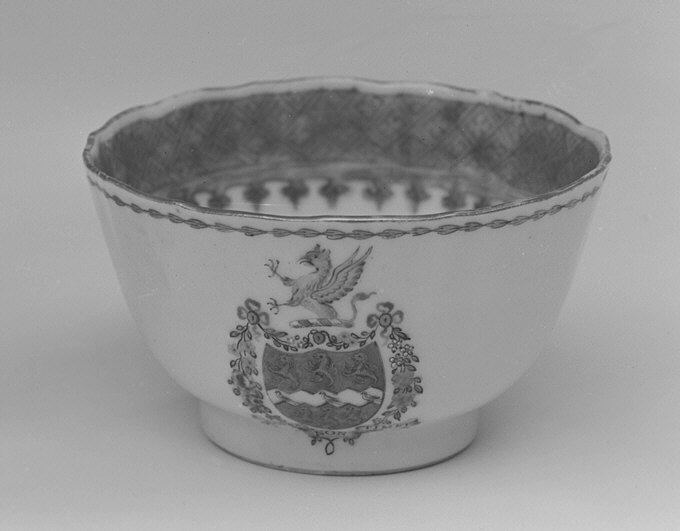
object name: cup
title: Cup (part of a service)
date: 1770-1785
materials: hard paste porcelain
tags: coat of arms